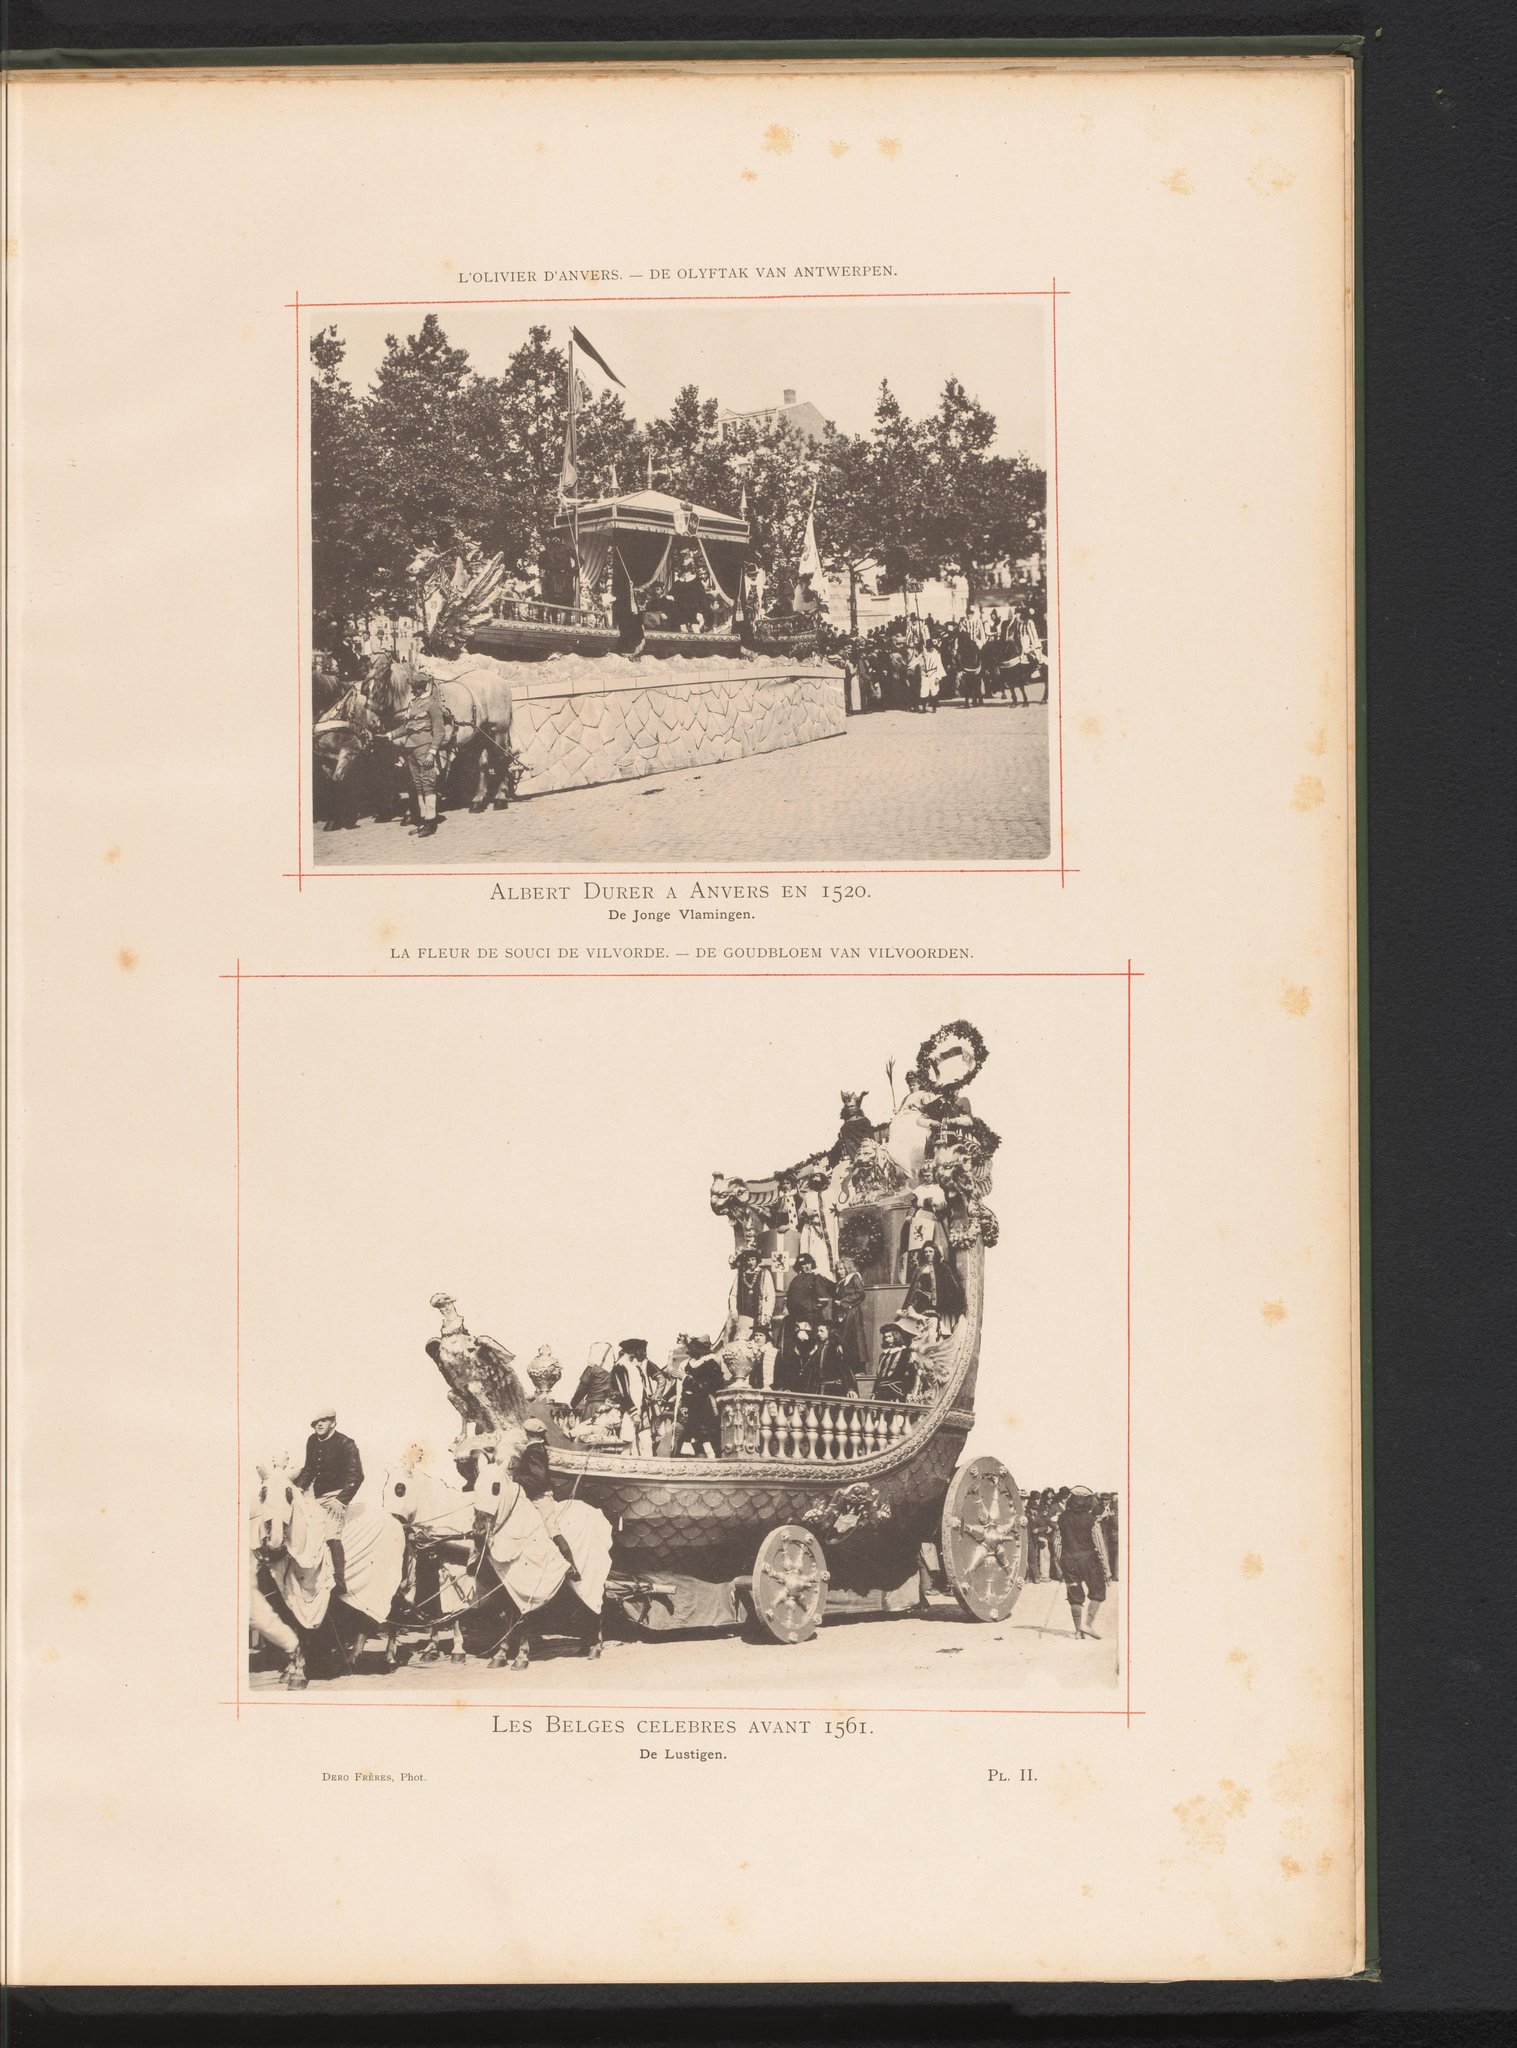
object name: photomechanical print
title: Les Belges Celebres avant 1561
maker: joseph maes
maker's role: fotograaf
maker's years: 1838-1908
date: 1892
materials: paper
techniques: photograph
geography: antwerp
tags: public festivities (+ parade, pageant, cavalcade ~ festive activities), antwerp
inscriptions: number: ‘Pl. II.’, inscription: ‘De Lustigen.’, inscription: ‘De Jonge Vlamingen.’, inscription: ‘L'OLIVIER D'ANVERS. - DE OLYFTAK VAN ANTWERPEN.’, inscription: ‘LA FLEUR DE SOUCI DE VILVORDE. - DE GOUDBLOEM VAN VILVOORDEN.’